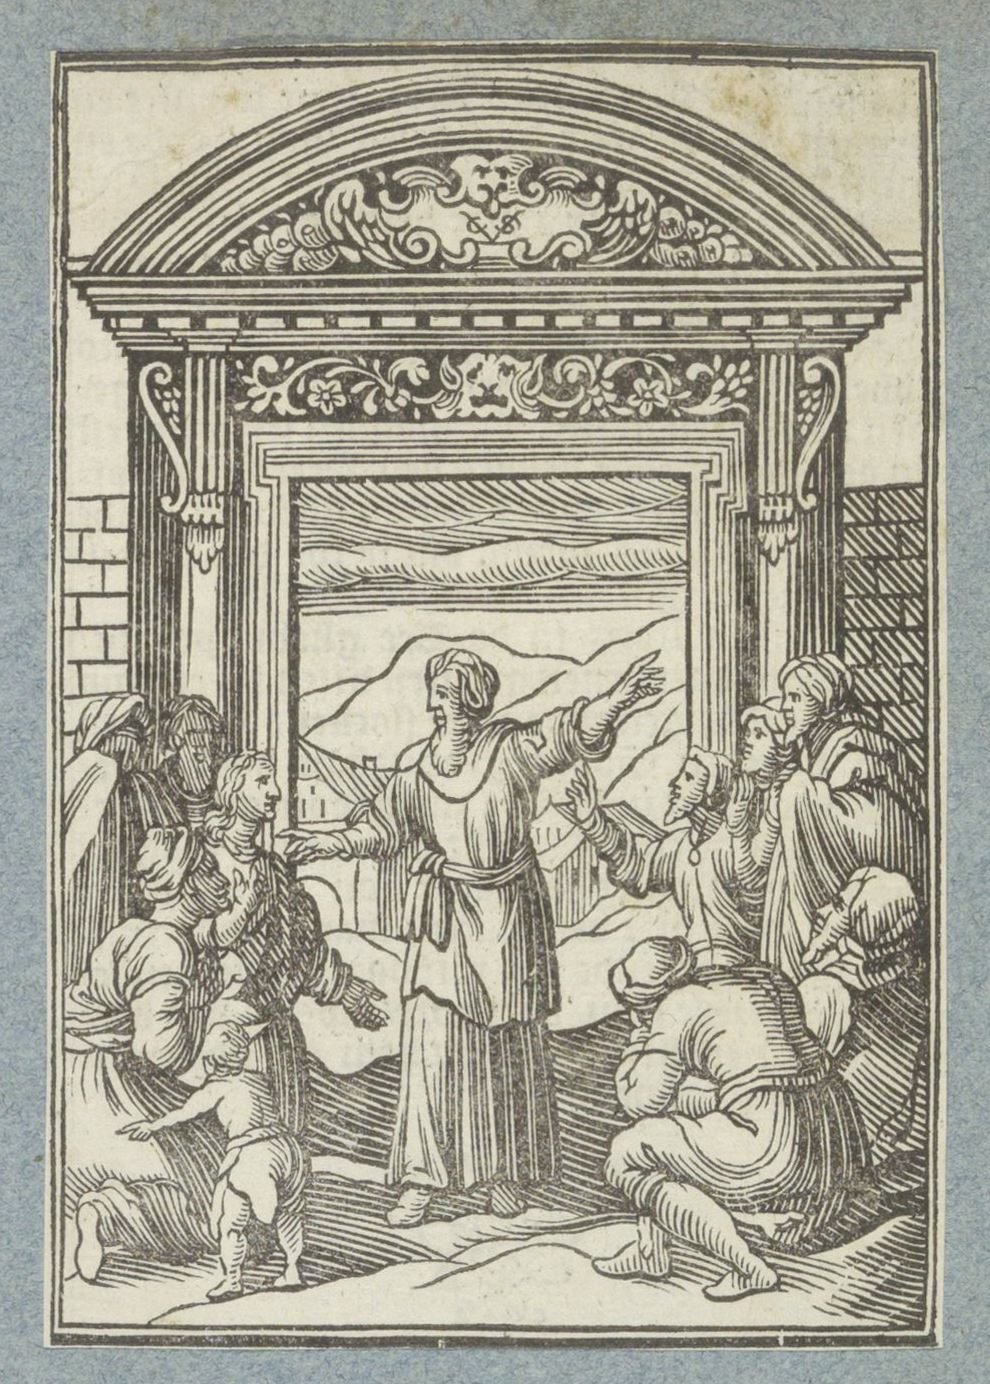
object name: book illustration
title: Jona in Nineve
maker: pieter jacobsz. paets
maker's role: publisher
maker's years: 1587-1667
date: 1645-1646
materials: paper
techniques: letterpress printing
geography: amsterdam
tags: when jonah arrives in the city of nineveh he foretells its destruction in forty days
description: De boekdruk op de verso van de prent betreft tekst uit het bijbelboek Jona. Ook andere prenten op hetzelfde albumblad verbeelden het verhaal van Jona. De prent werd gemaakt voor de uitgaven van P.J. Paets uit Amsterdam. Ze komt in ieder geval voor in: Bibels Tresoor ofte der zielen lusthof. Amsterdam, P.J. Paets, 1646. Mogelijk ook in: Historien ende Prophetien. [Amsterdam], P.J. Paets, 1645.